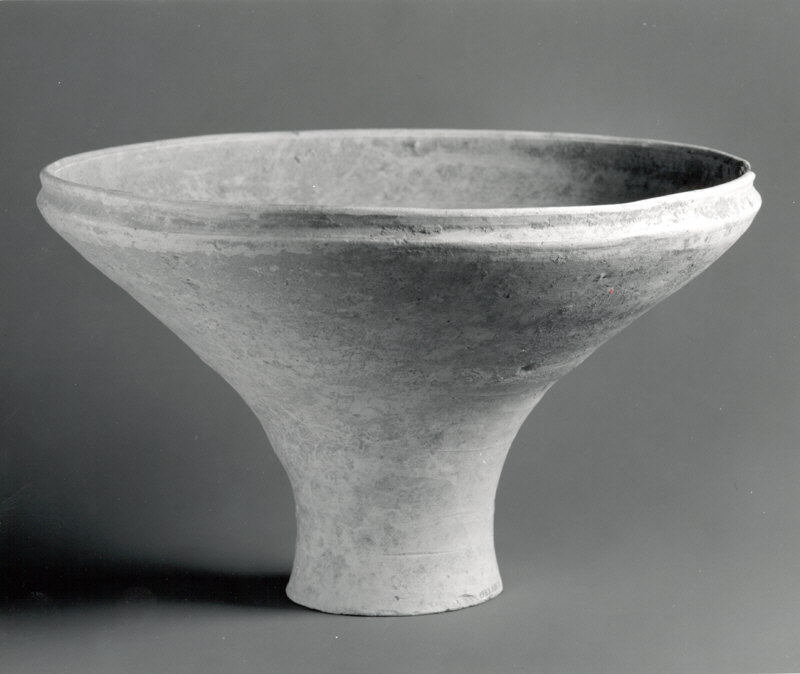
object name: vessel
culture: bactria-margiana archaeological complex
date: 2333-1668 BCE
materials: ceramic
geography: bactria-margiana